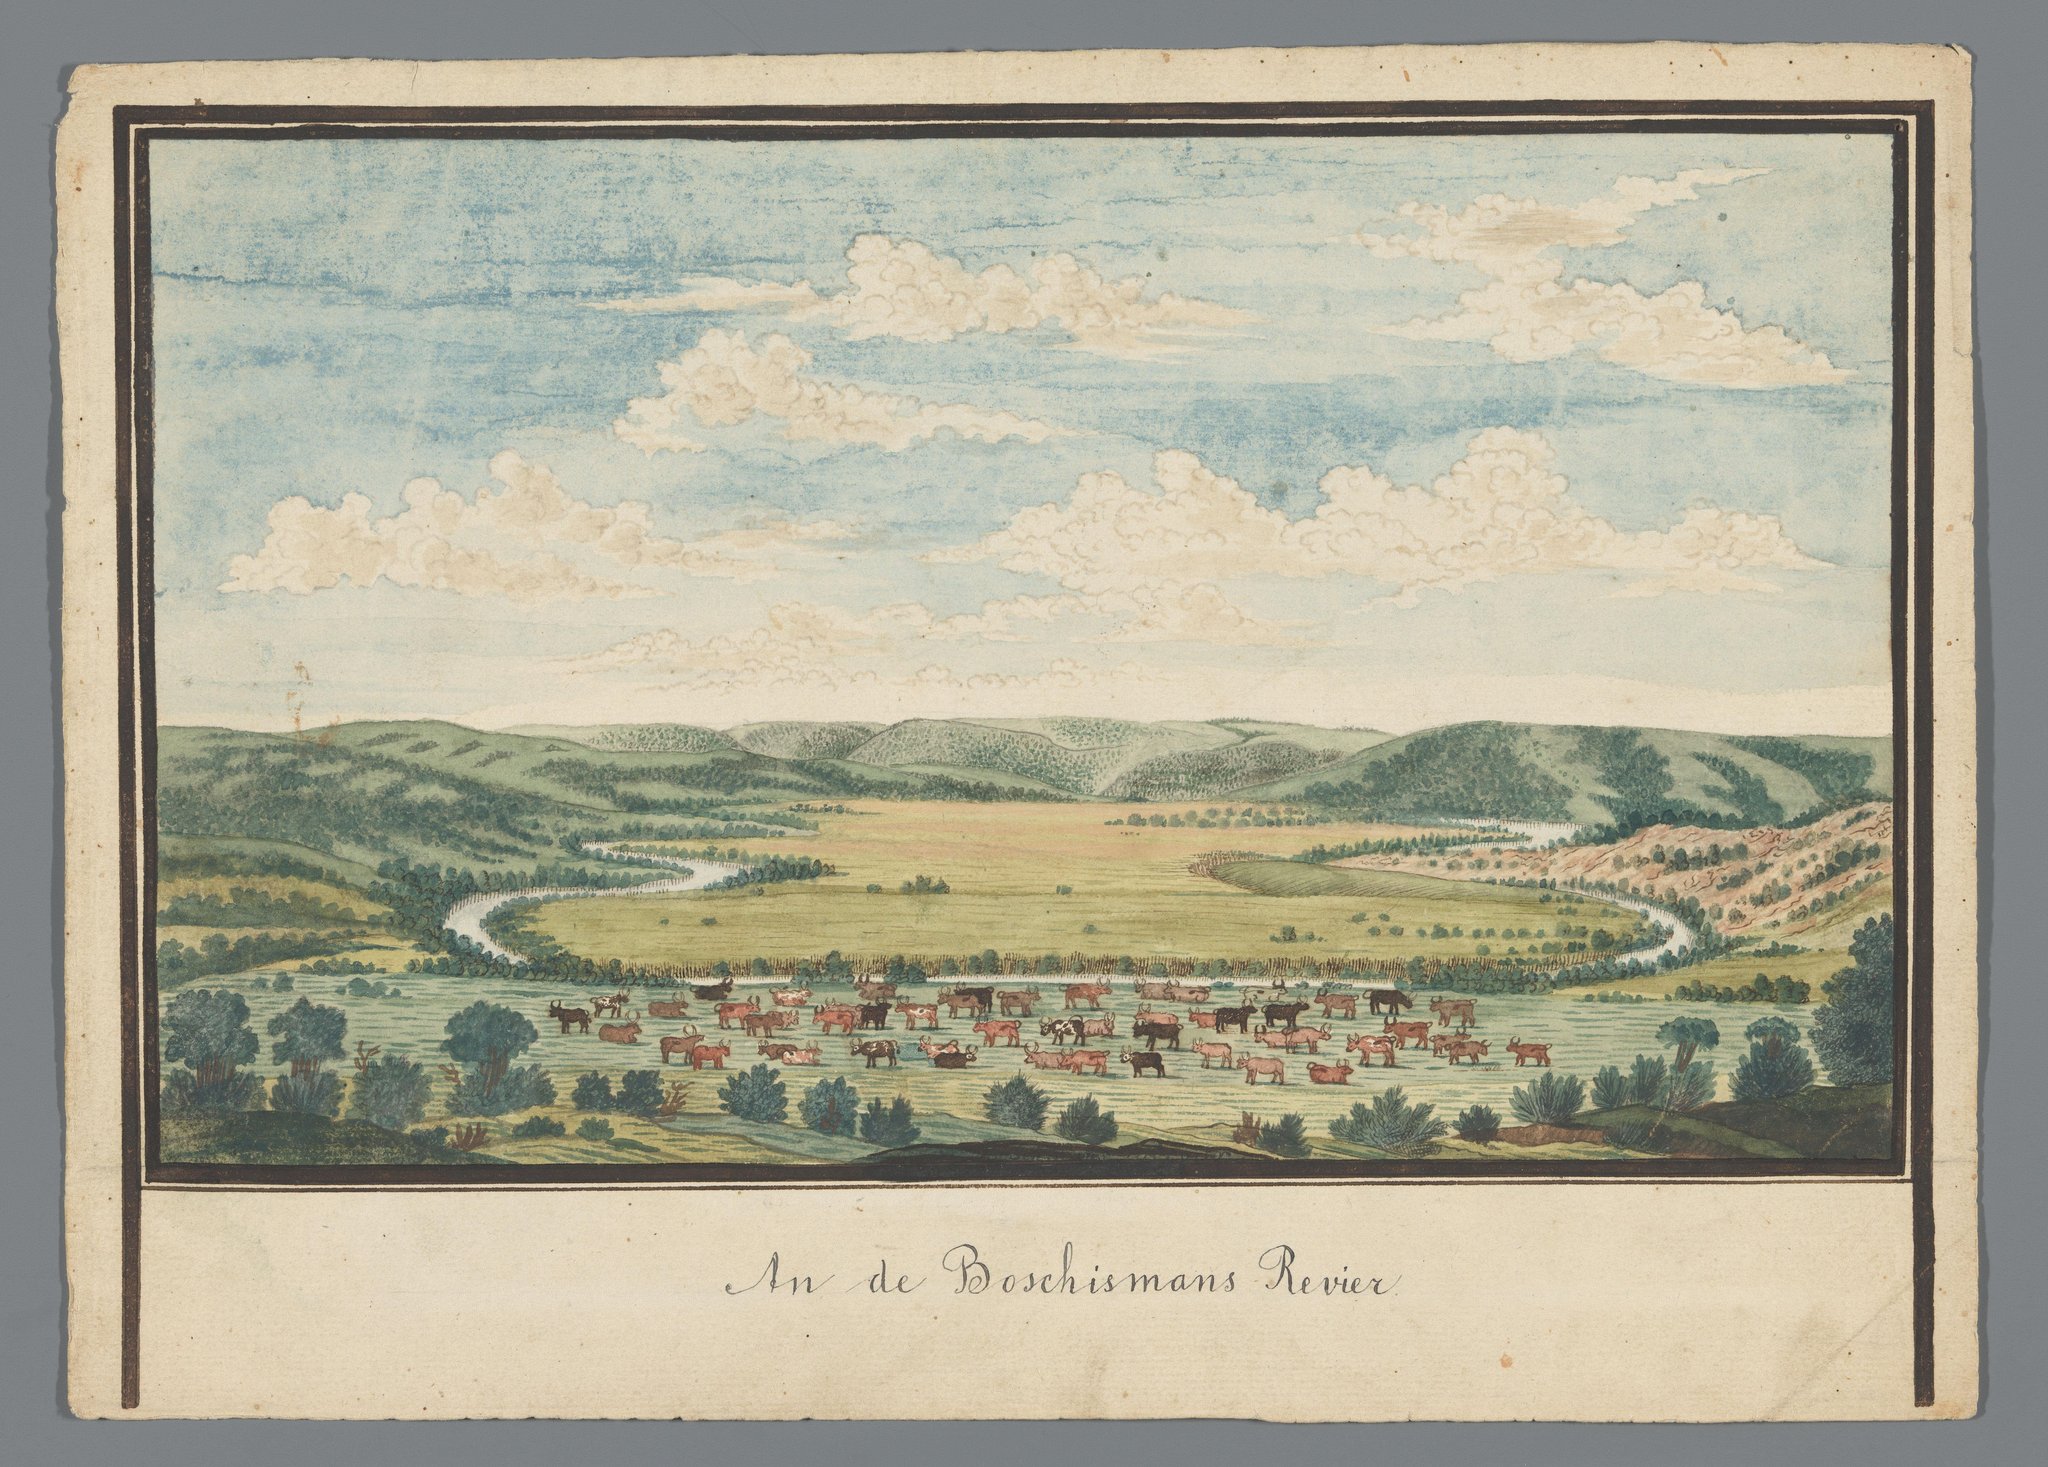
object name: drawing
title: Bij de Boesmansrivier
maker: johannes schumacher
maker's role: draughtsman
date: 1711-1776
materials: paper, watercolor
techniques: brush, pen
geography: south africa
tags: cape of good hope, river, bovine cattle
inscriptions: label: ‘19’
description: Gezicht op het vee grazend bij de oevers van de Boesmansrivier (Boesmans River) in het Suurveld. Tekening gemaakt in november tijdens de tweede reis van Hendrik Swellengrebel, naar het noordoosten van de Kaapkolonie, 10 september - 26 december 1776. Volgens het reisjournaal arriveert het gezelschap bij de rivier op 5 november 1776.